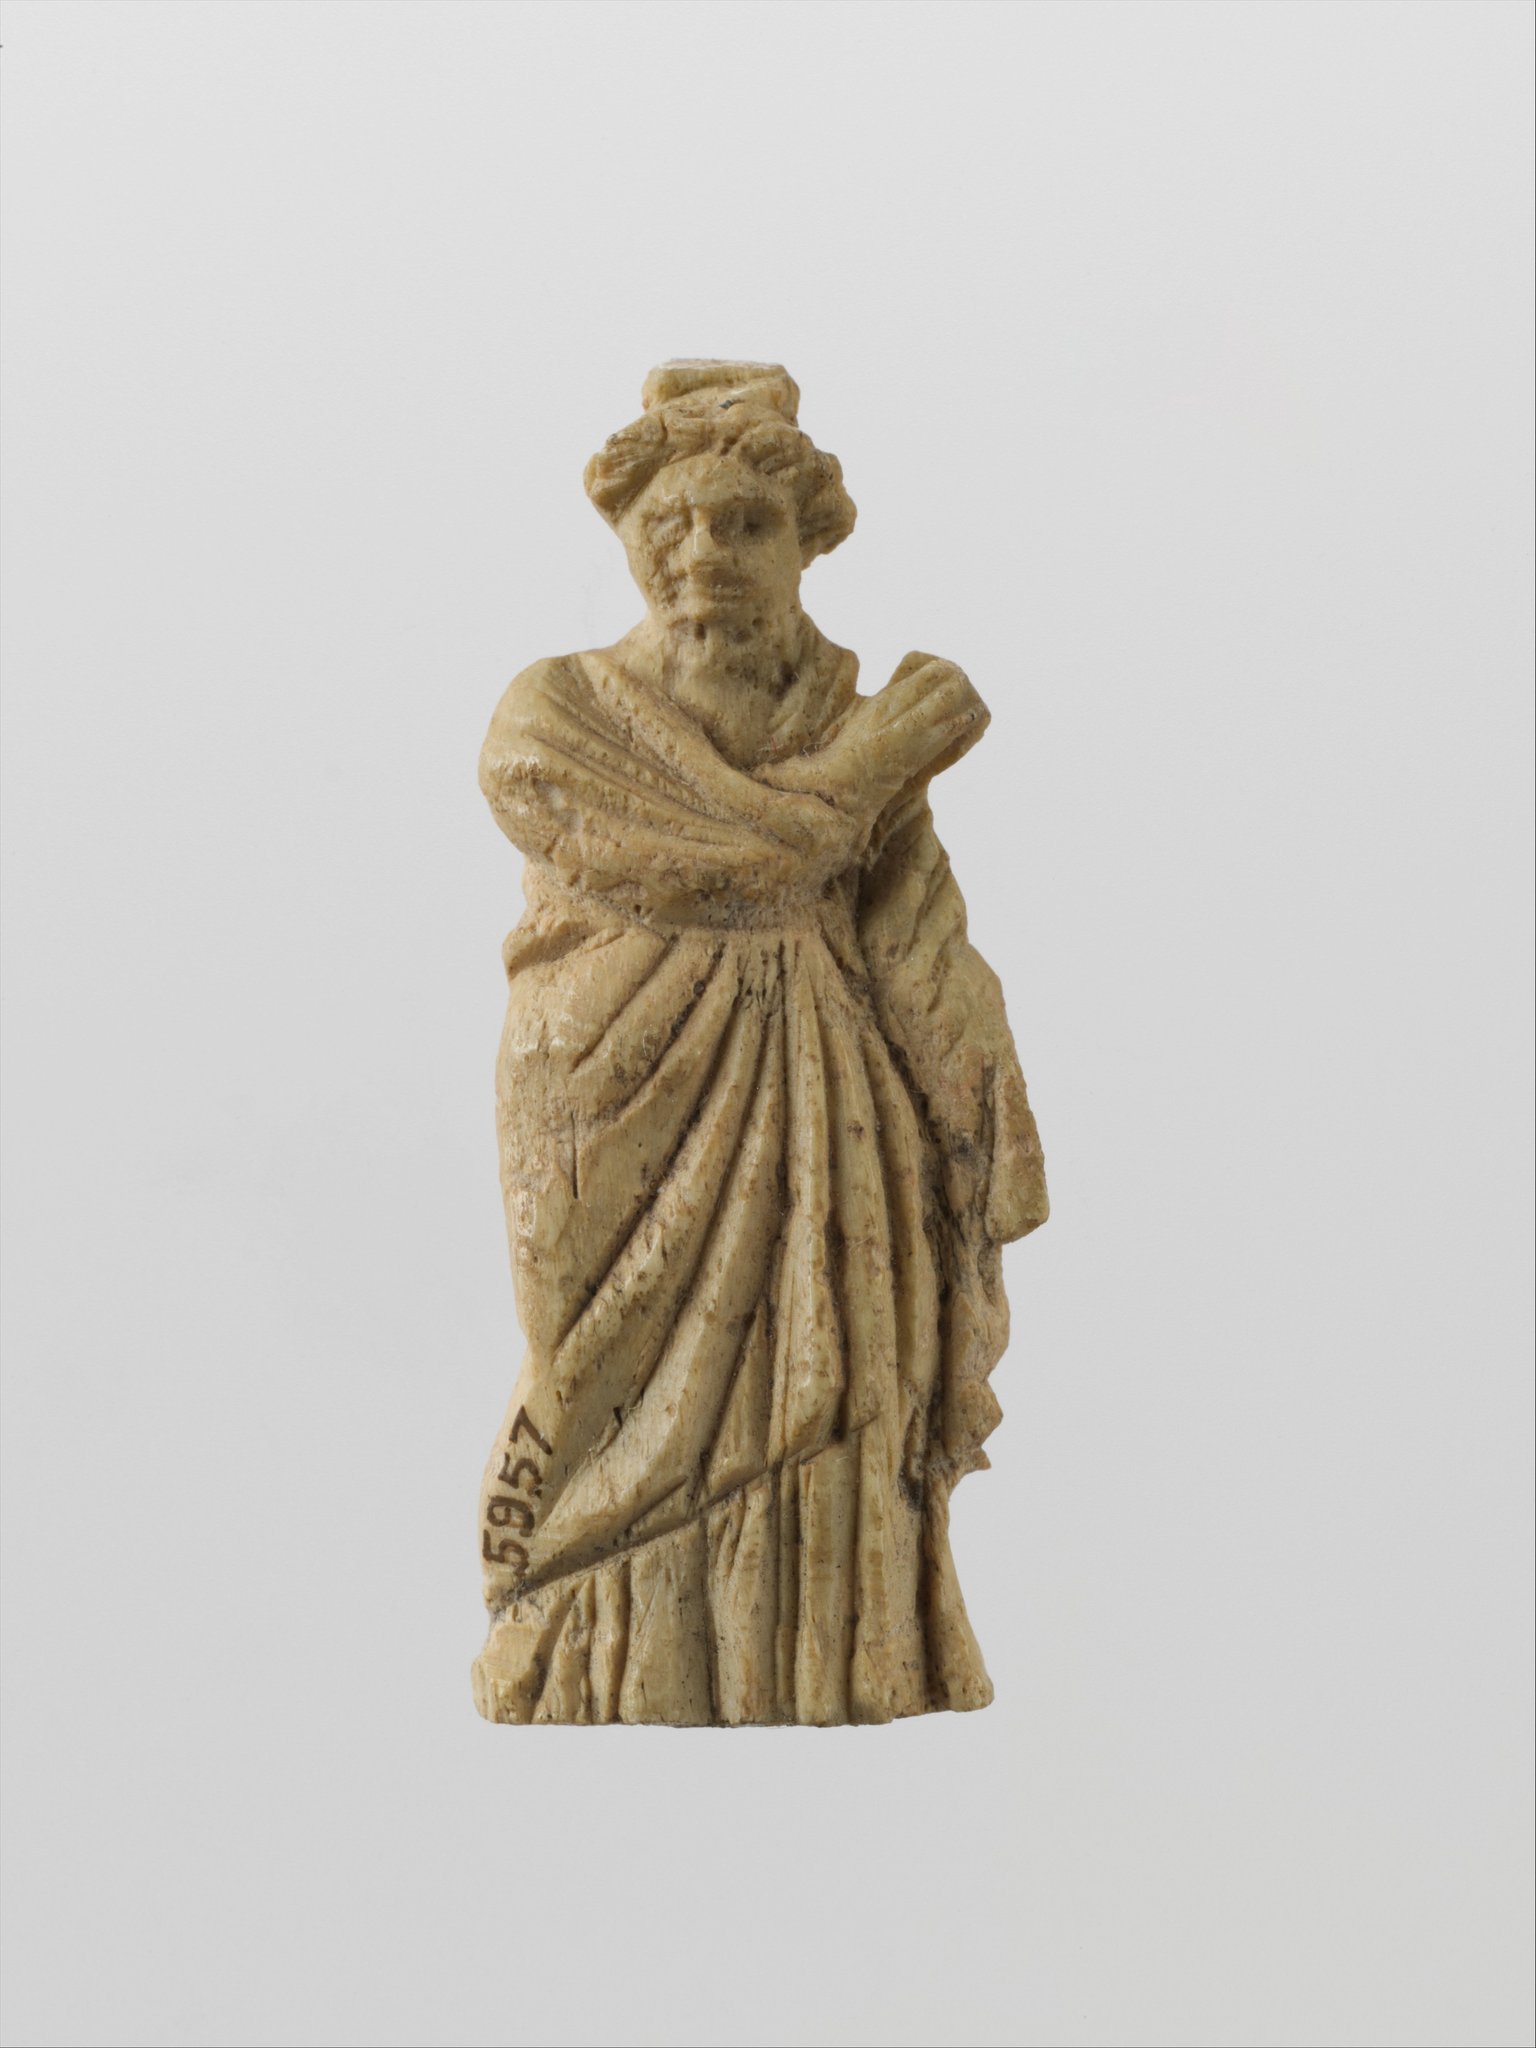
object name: statuette of a woman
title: Bone statuette of a draped woman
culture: greek or roman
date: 101-300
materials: bone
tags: women